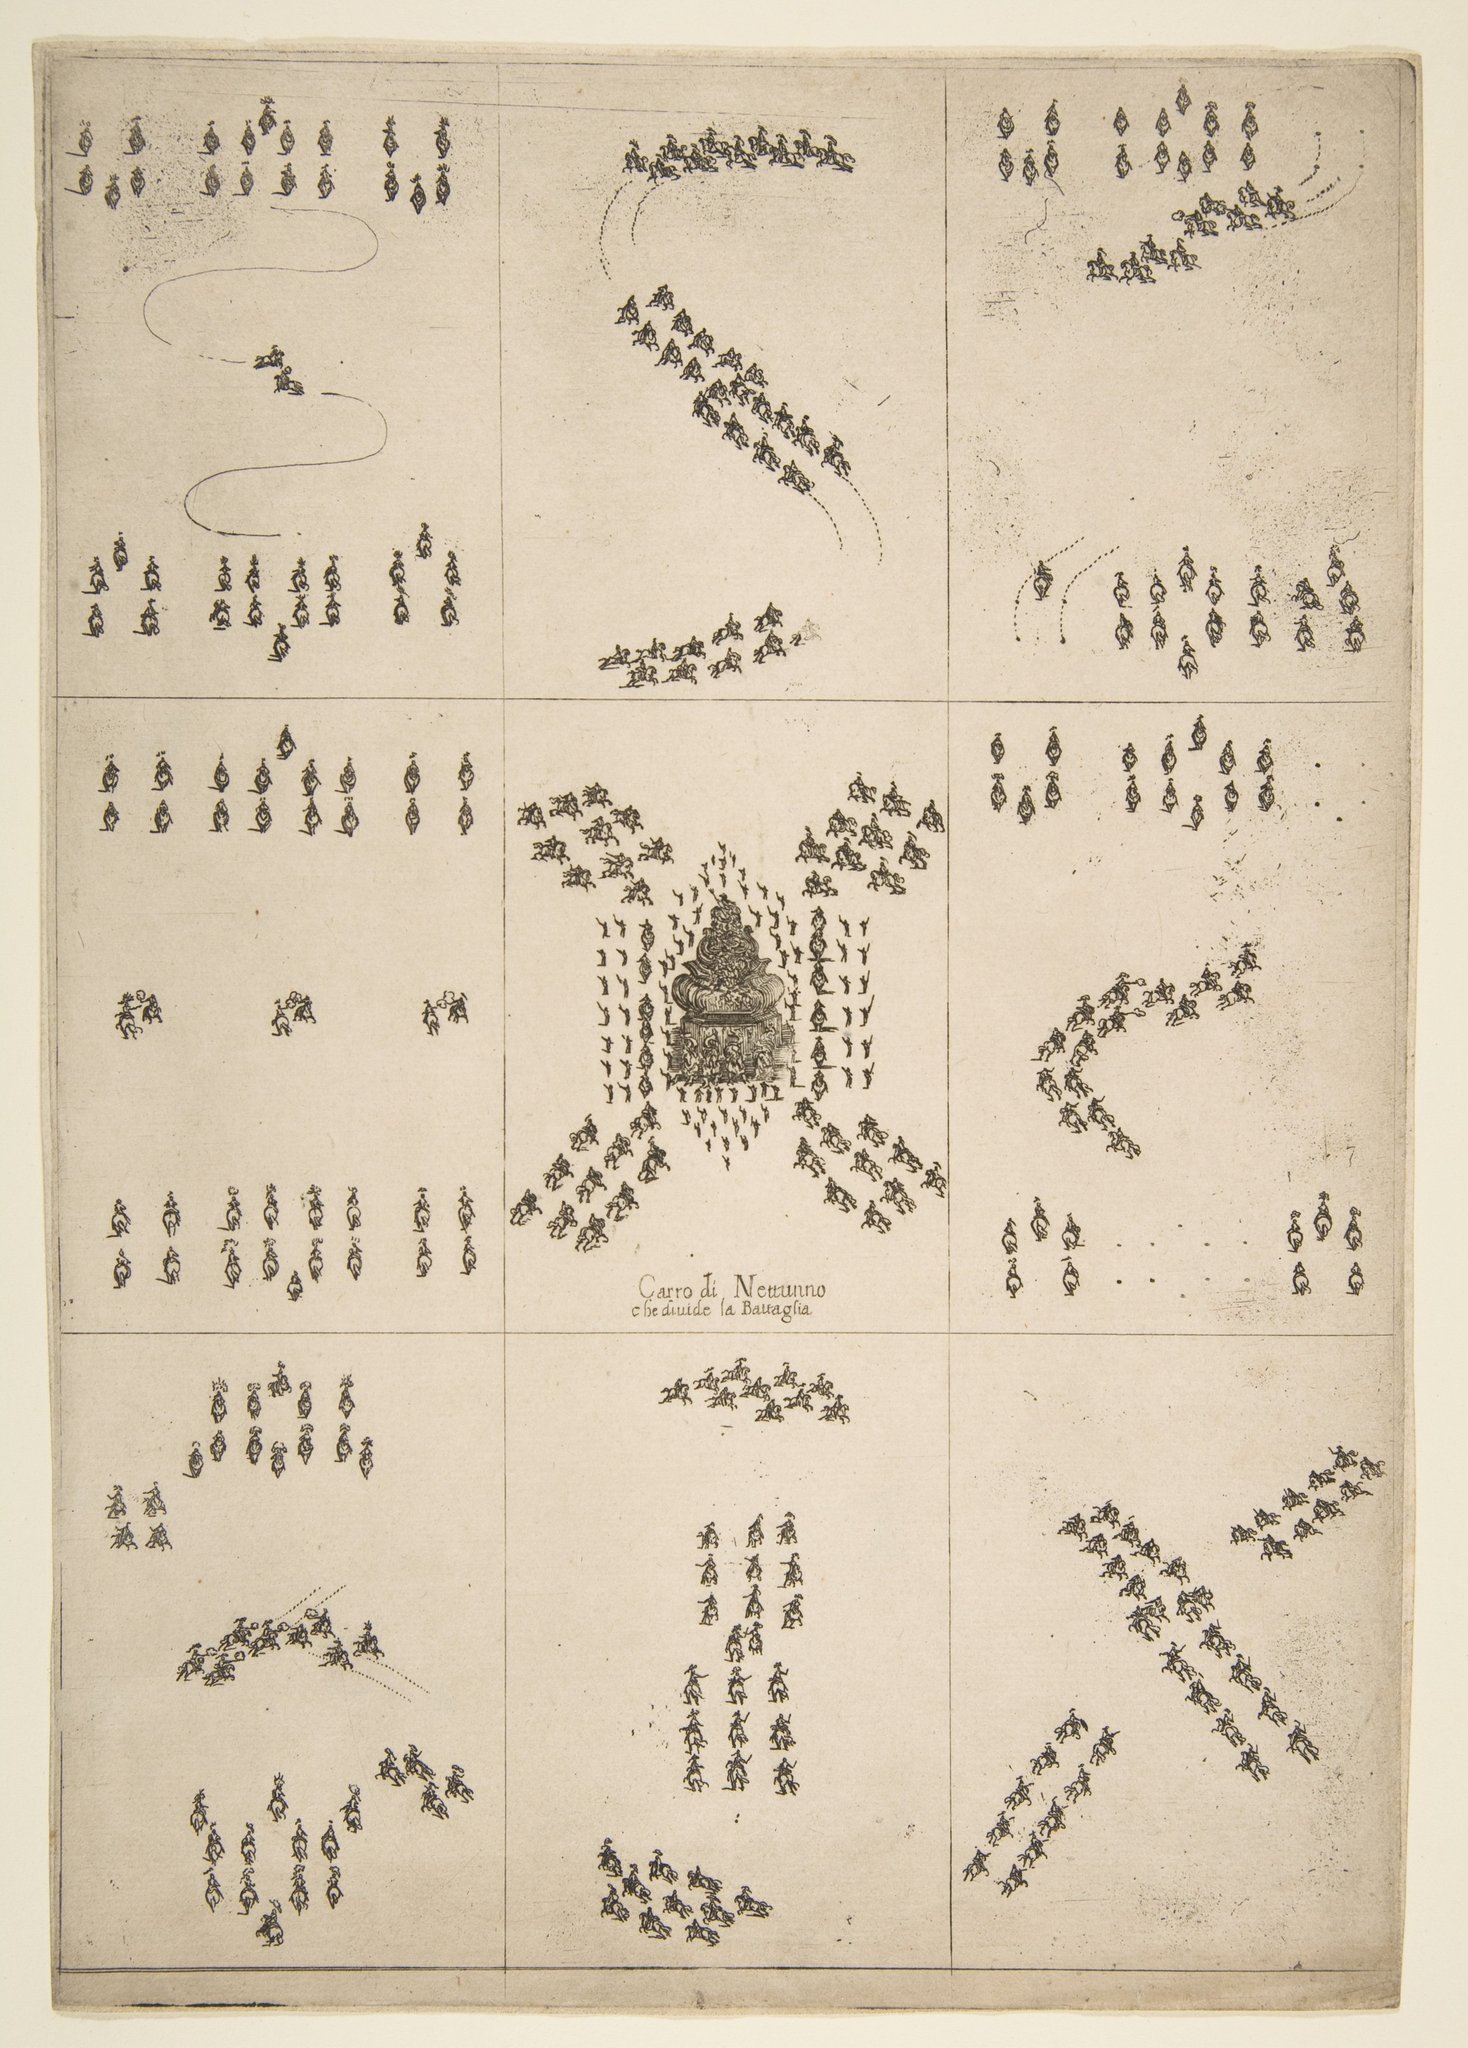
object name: print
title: Various figures of horse ballet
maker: stefano della bella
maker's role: artist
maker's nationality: italian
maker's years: 1610-1664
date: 1652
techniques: etching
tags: horses,ballet